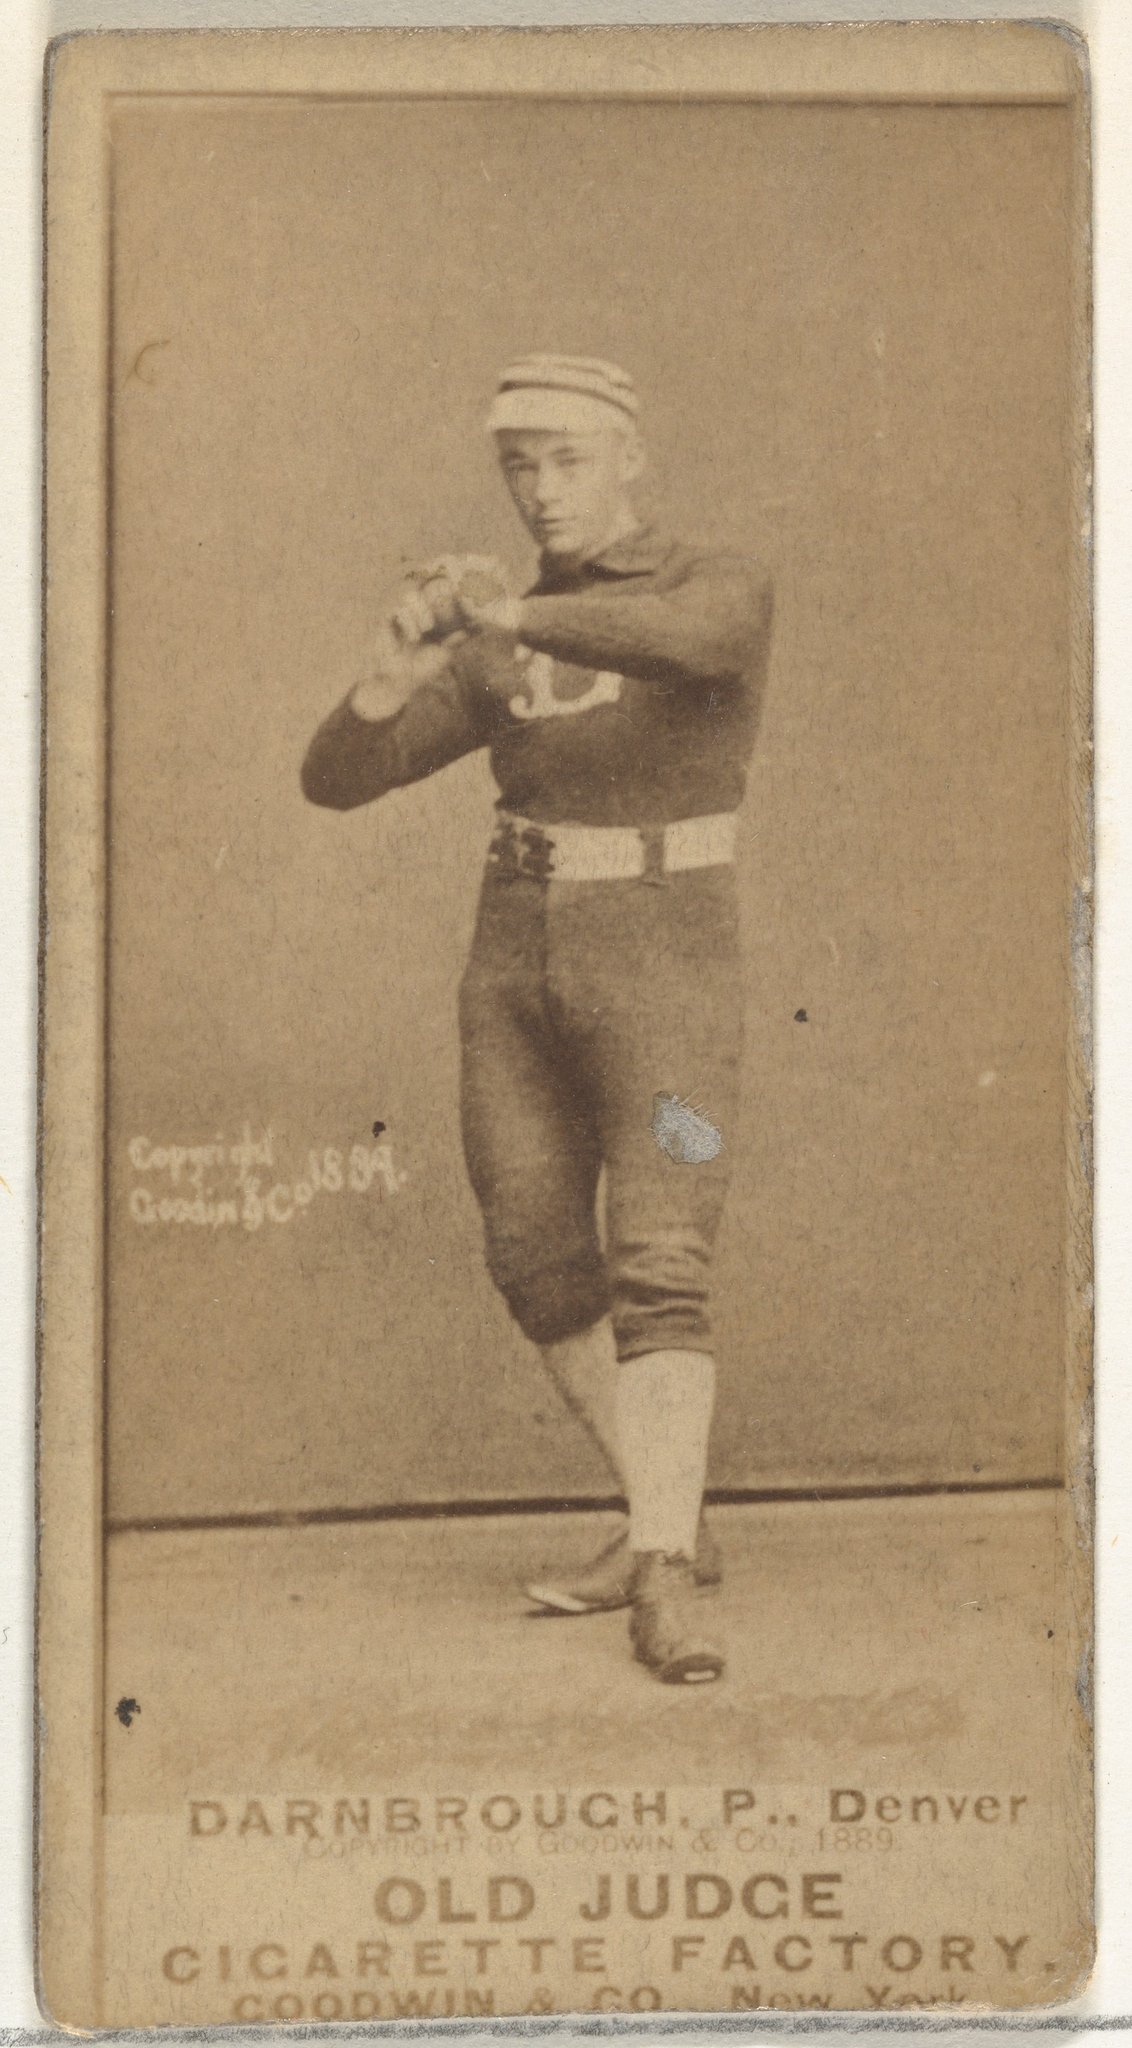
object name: baseball card, photograph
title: William Darnbrough, Pitcher, Denver, from the Old Judge series (N172) for Old Judge Cigarettes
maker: goodwin & company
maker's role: publisher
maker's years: 1850-1950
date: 1889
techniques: albumen silver print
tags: men,portraits,baseball,athletes